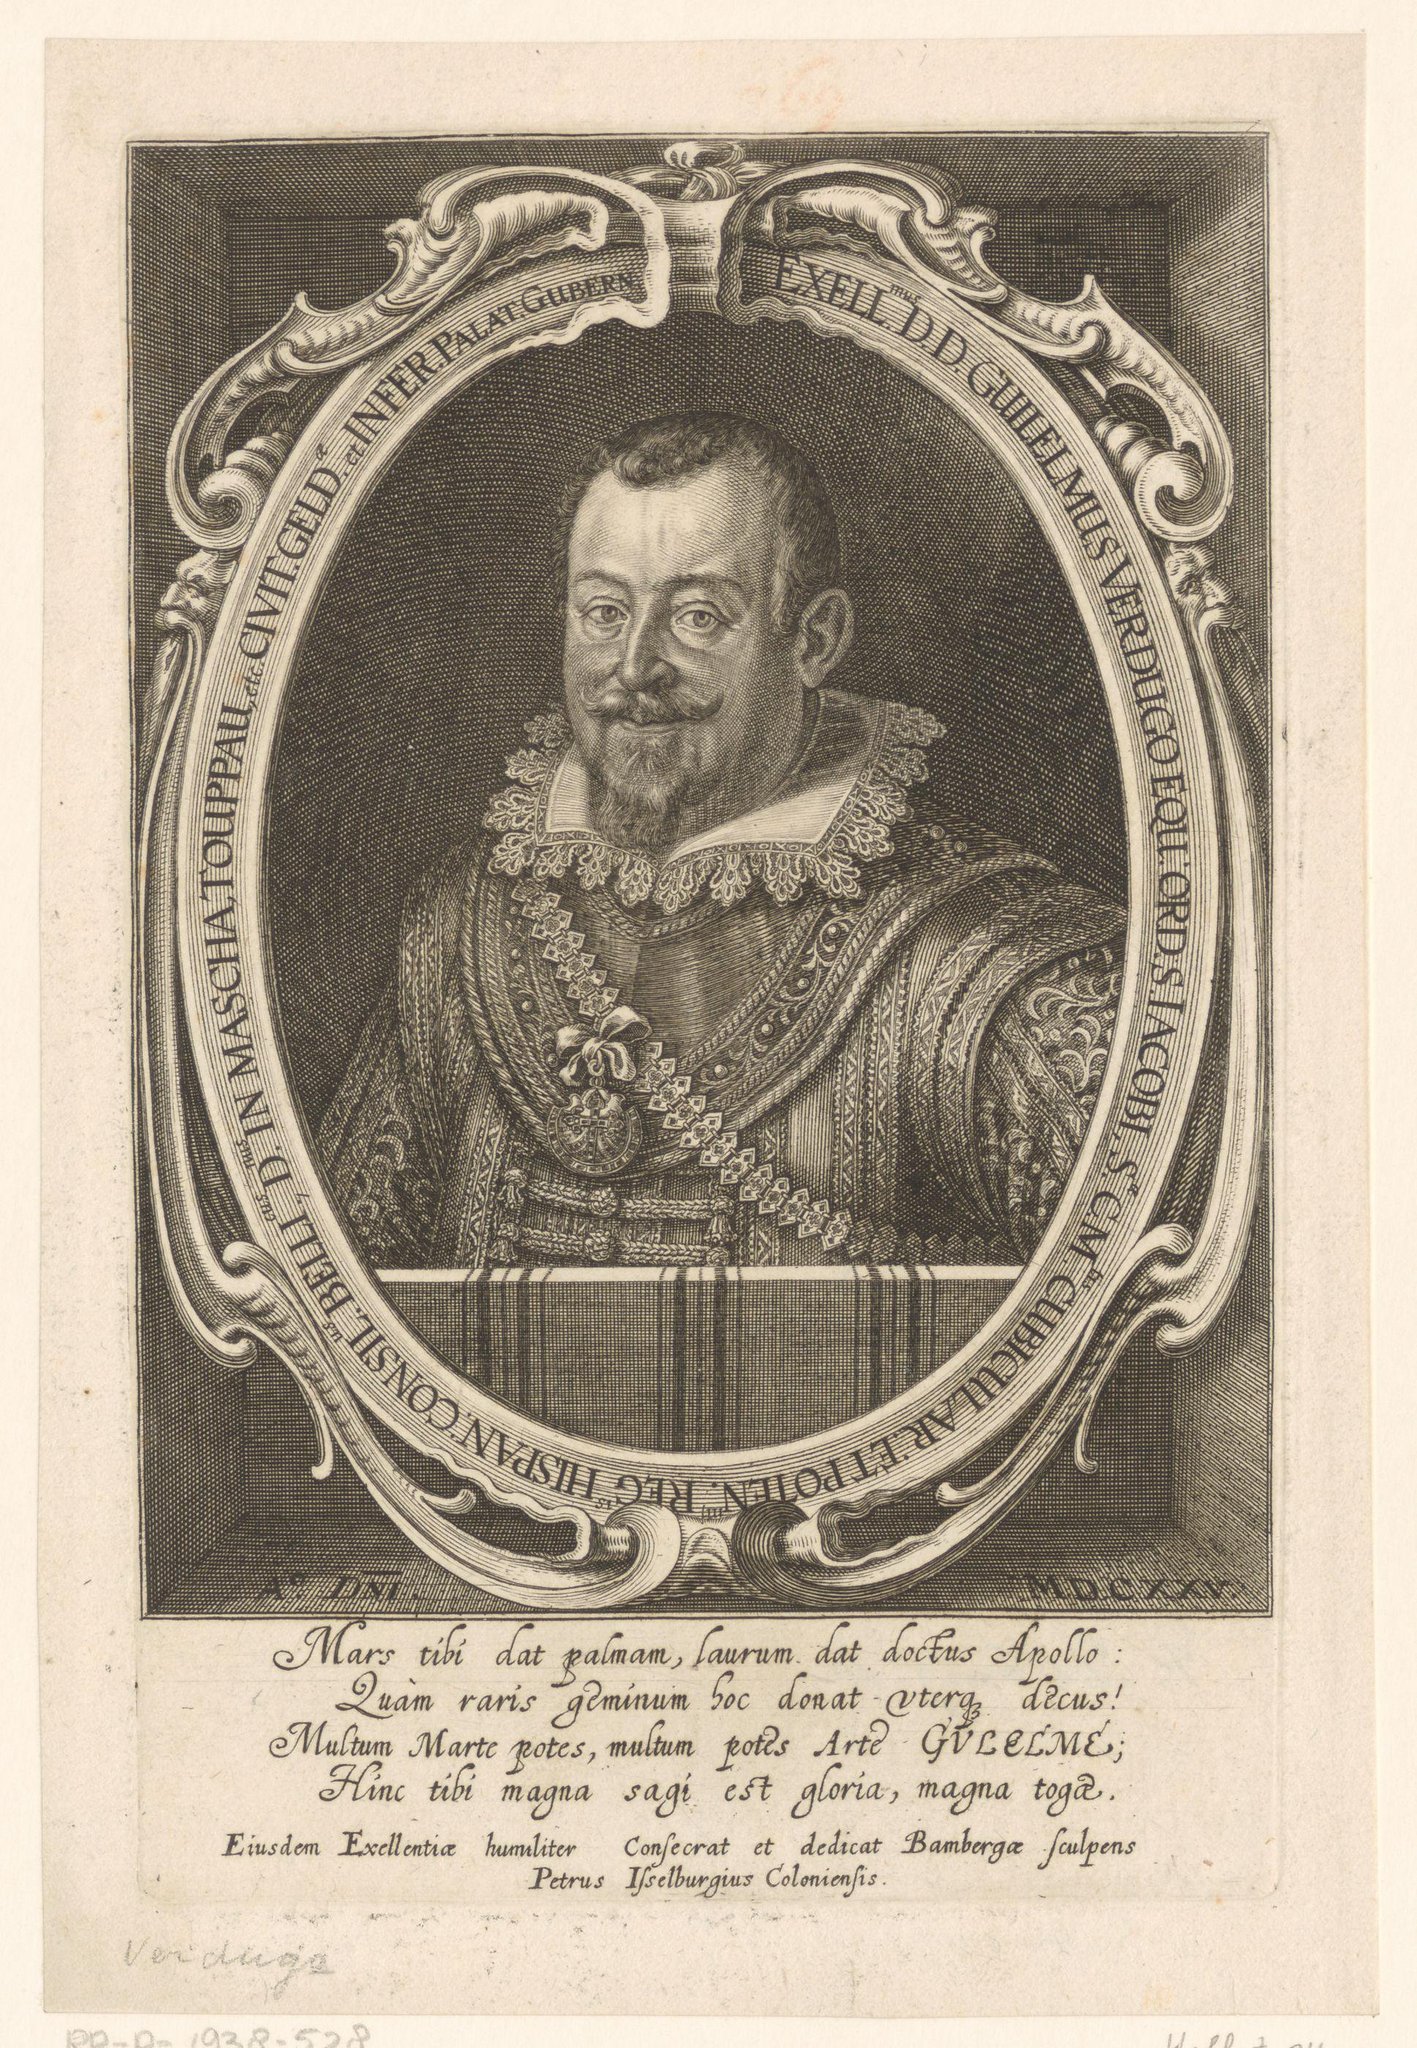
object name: print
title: Portret van Wilhelm Verdugo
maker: peter isselburg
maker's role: print maker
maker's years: 1568-1630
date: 1588-1630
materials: paper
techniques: engraving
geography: cologne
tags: commander-in-chief, general, marshal, historical persons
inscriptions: collector's mark: Lugt 964, collector's mark: Lugt 2228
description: Portret van Wilhelm Verdugo (Guilelmus Verdugo) in medaillon met tekst in het Latijn in de omlijsting en marge.